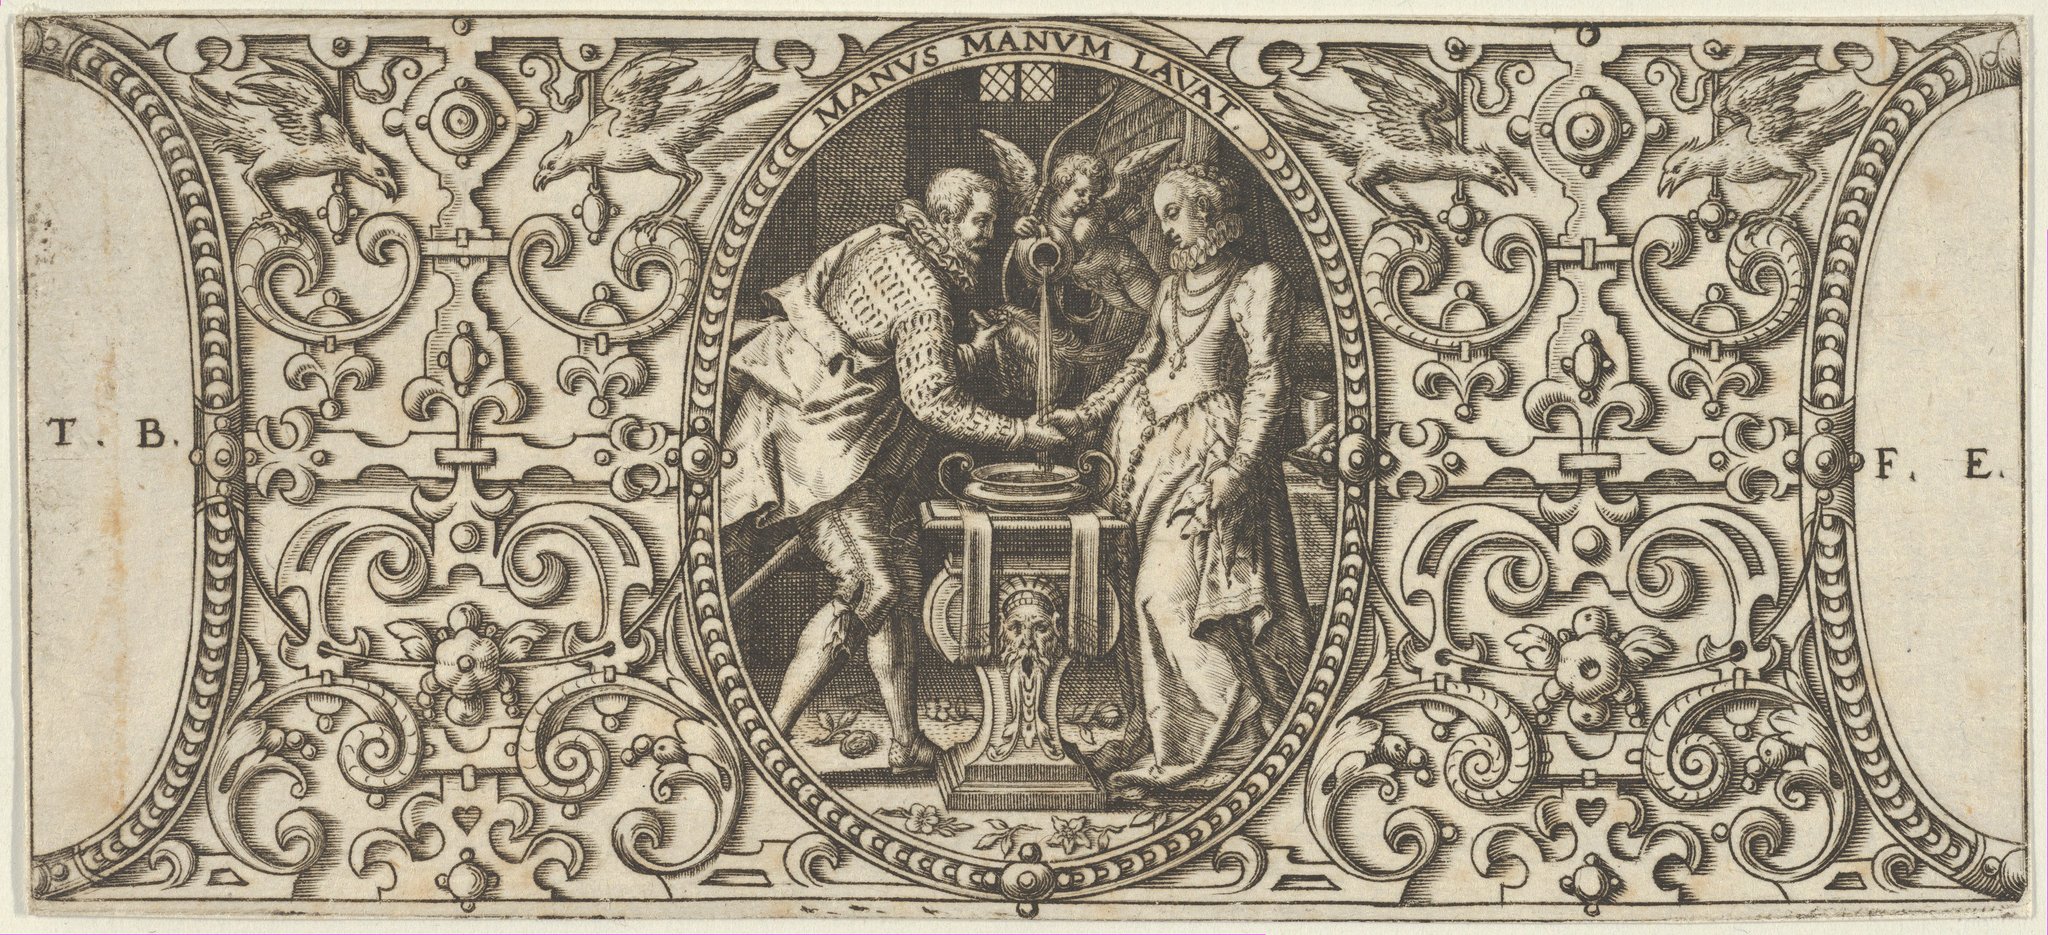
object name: print ornament architecture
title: A Couple Shaking Hands, from Grotisch fur alle Kunstler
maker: theodor de bry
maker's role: artist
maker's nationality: netherlandish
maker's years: 1528-1598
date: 1580-1600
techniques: engraving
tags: birds,couples,men,women,putti